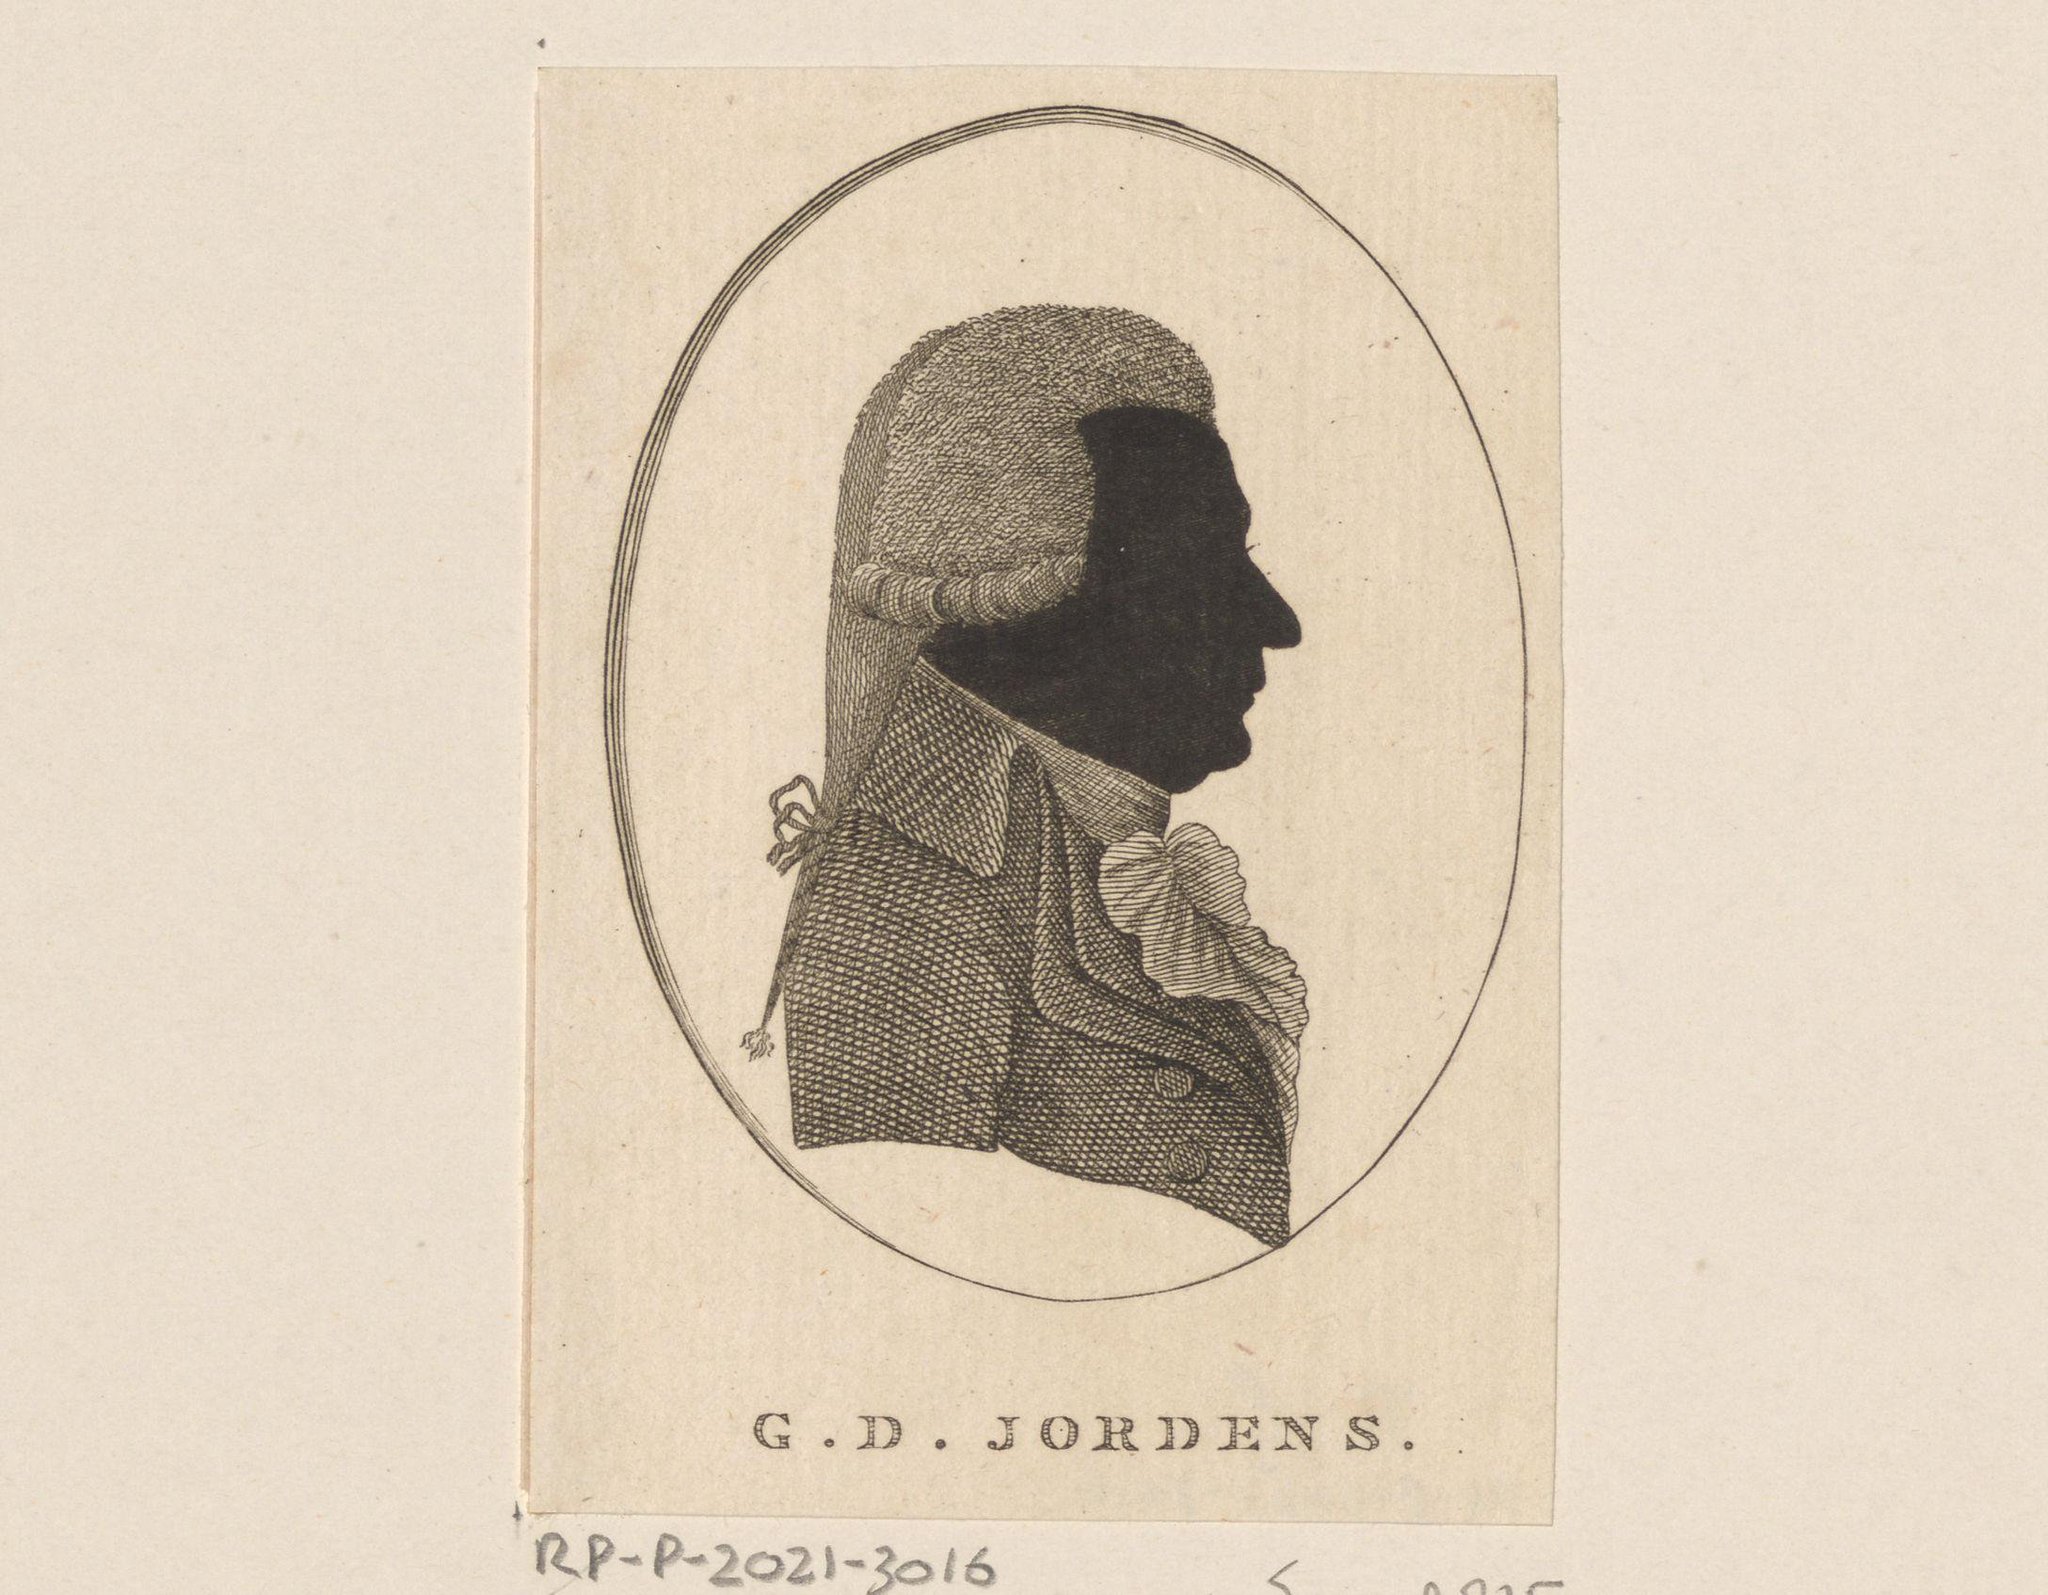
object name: print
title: Silhouetportret van Gerhard David Jordens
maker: Anonymous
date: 1799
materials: paper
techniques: engraving, etching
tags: deventer, politician, historical persons, politician, e.g. party leader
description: Prent maakt deel uit van een grotere prent met portretten die later is verknipt. Prent mogelijk uit: Rogge, Cornelis. Geschiedenis der staatsregeling, voor het Bataafsche volk. Amsterdam: Johannes Allart, 1799.